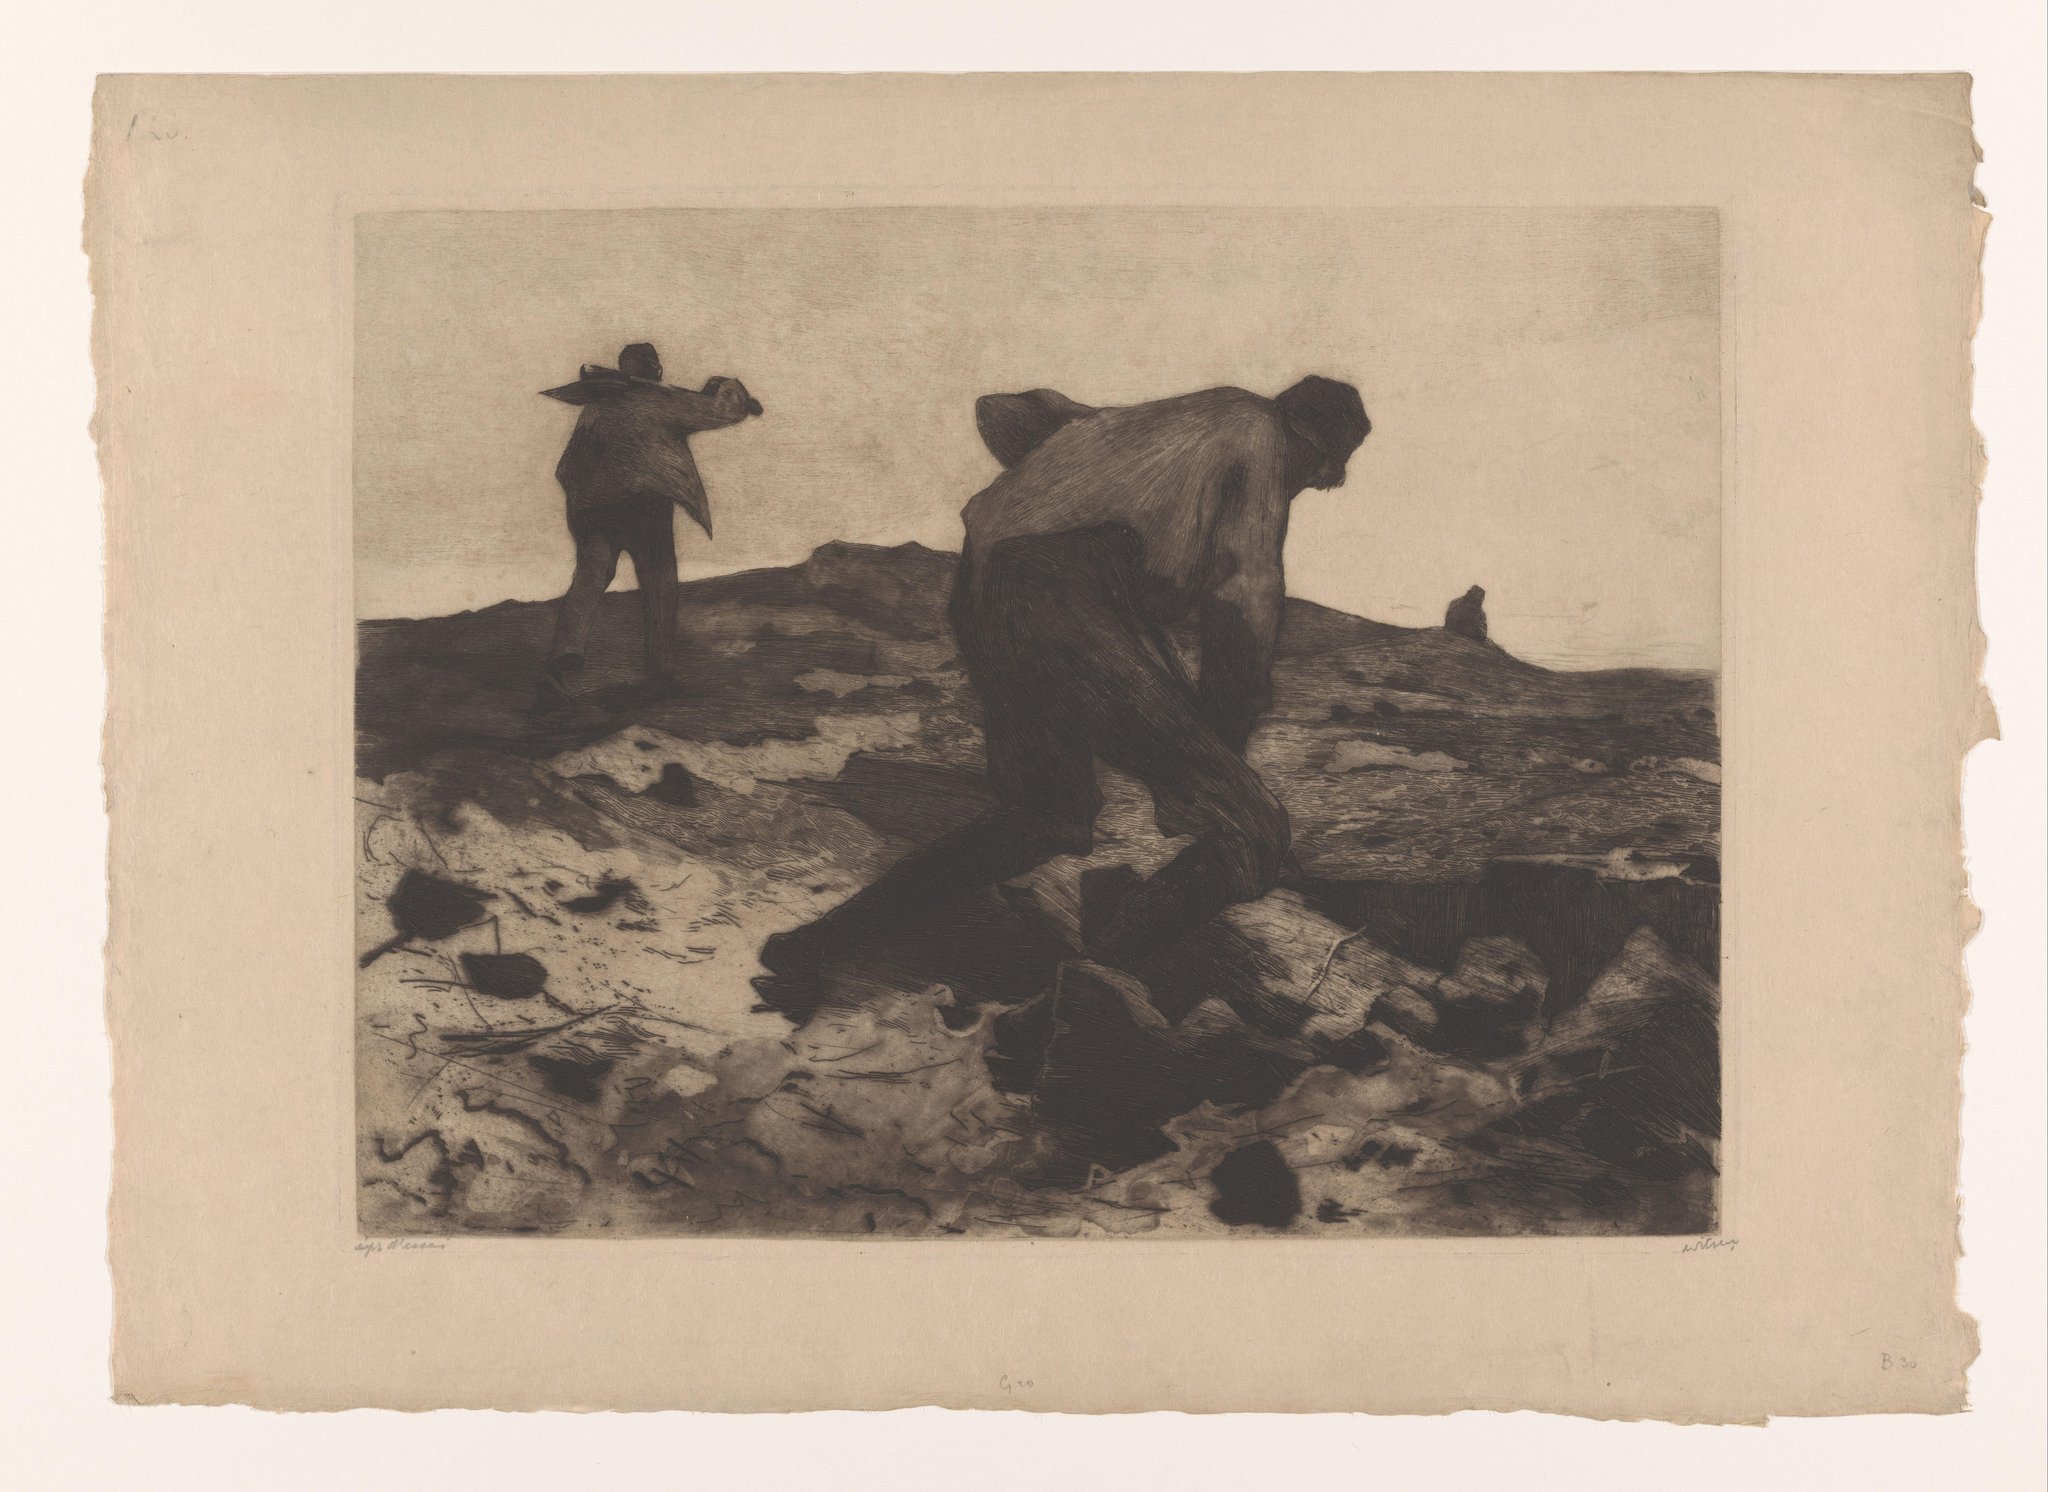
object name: print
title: Landarbeiders op de heide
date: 1886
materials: paper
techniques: aquatint, etching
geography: brussels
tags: peat-cutting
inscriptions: annotation: ‘épr d'essai’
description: Links loopt een man met spade over de schouder weg. Op de achtergrond zijn nog juist het hoofd en de schouders van een man te zien.